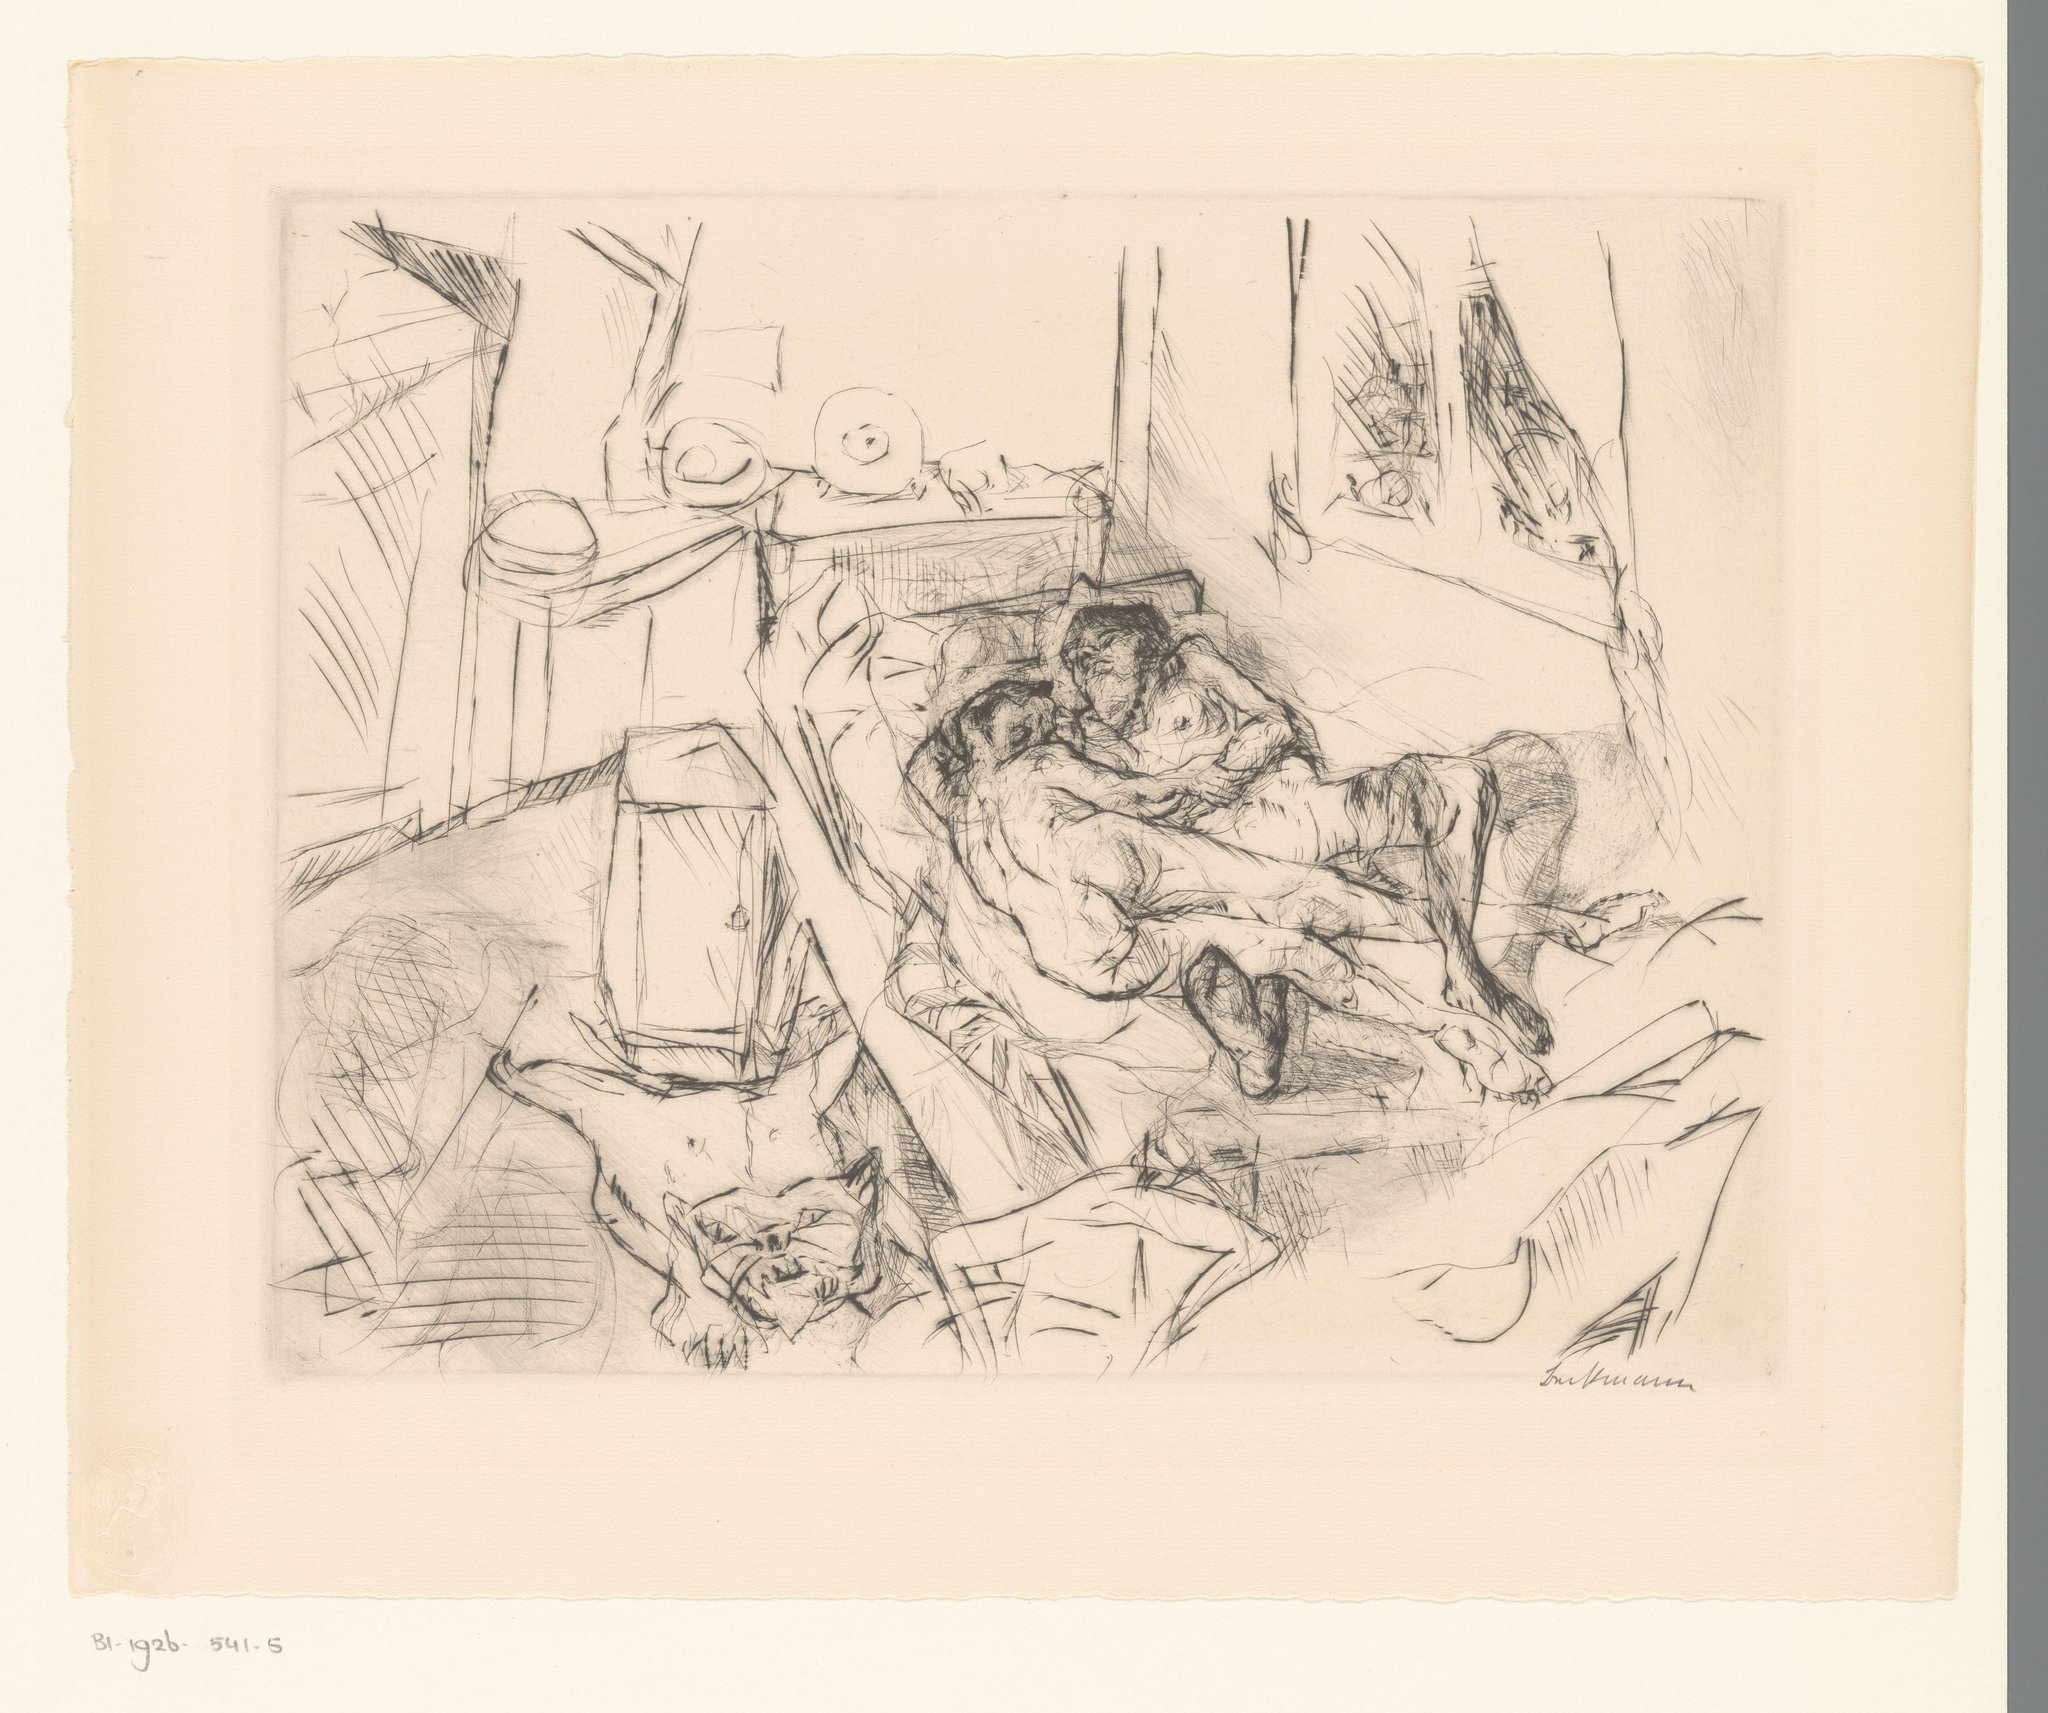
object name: print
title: Vrijend paar op een bed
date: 1916-1919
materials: paper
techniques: drypoint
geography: munich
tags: couple of lovers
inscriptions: collector's mark: Lugt 2166, collector's mark: Lugt 5629